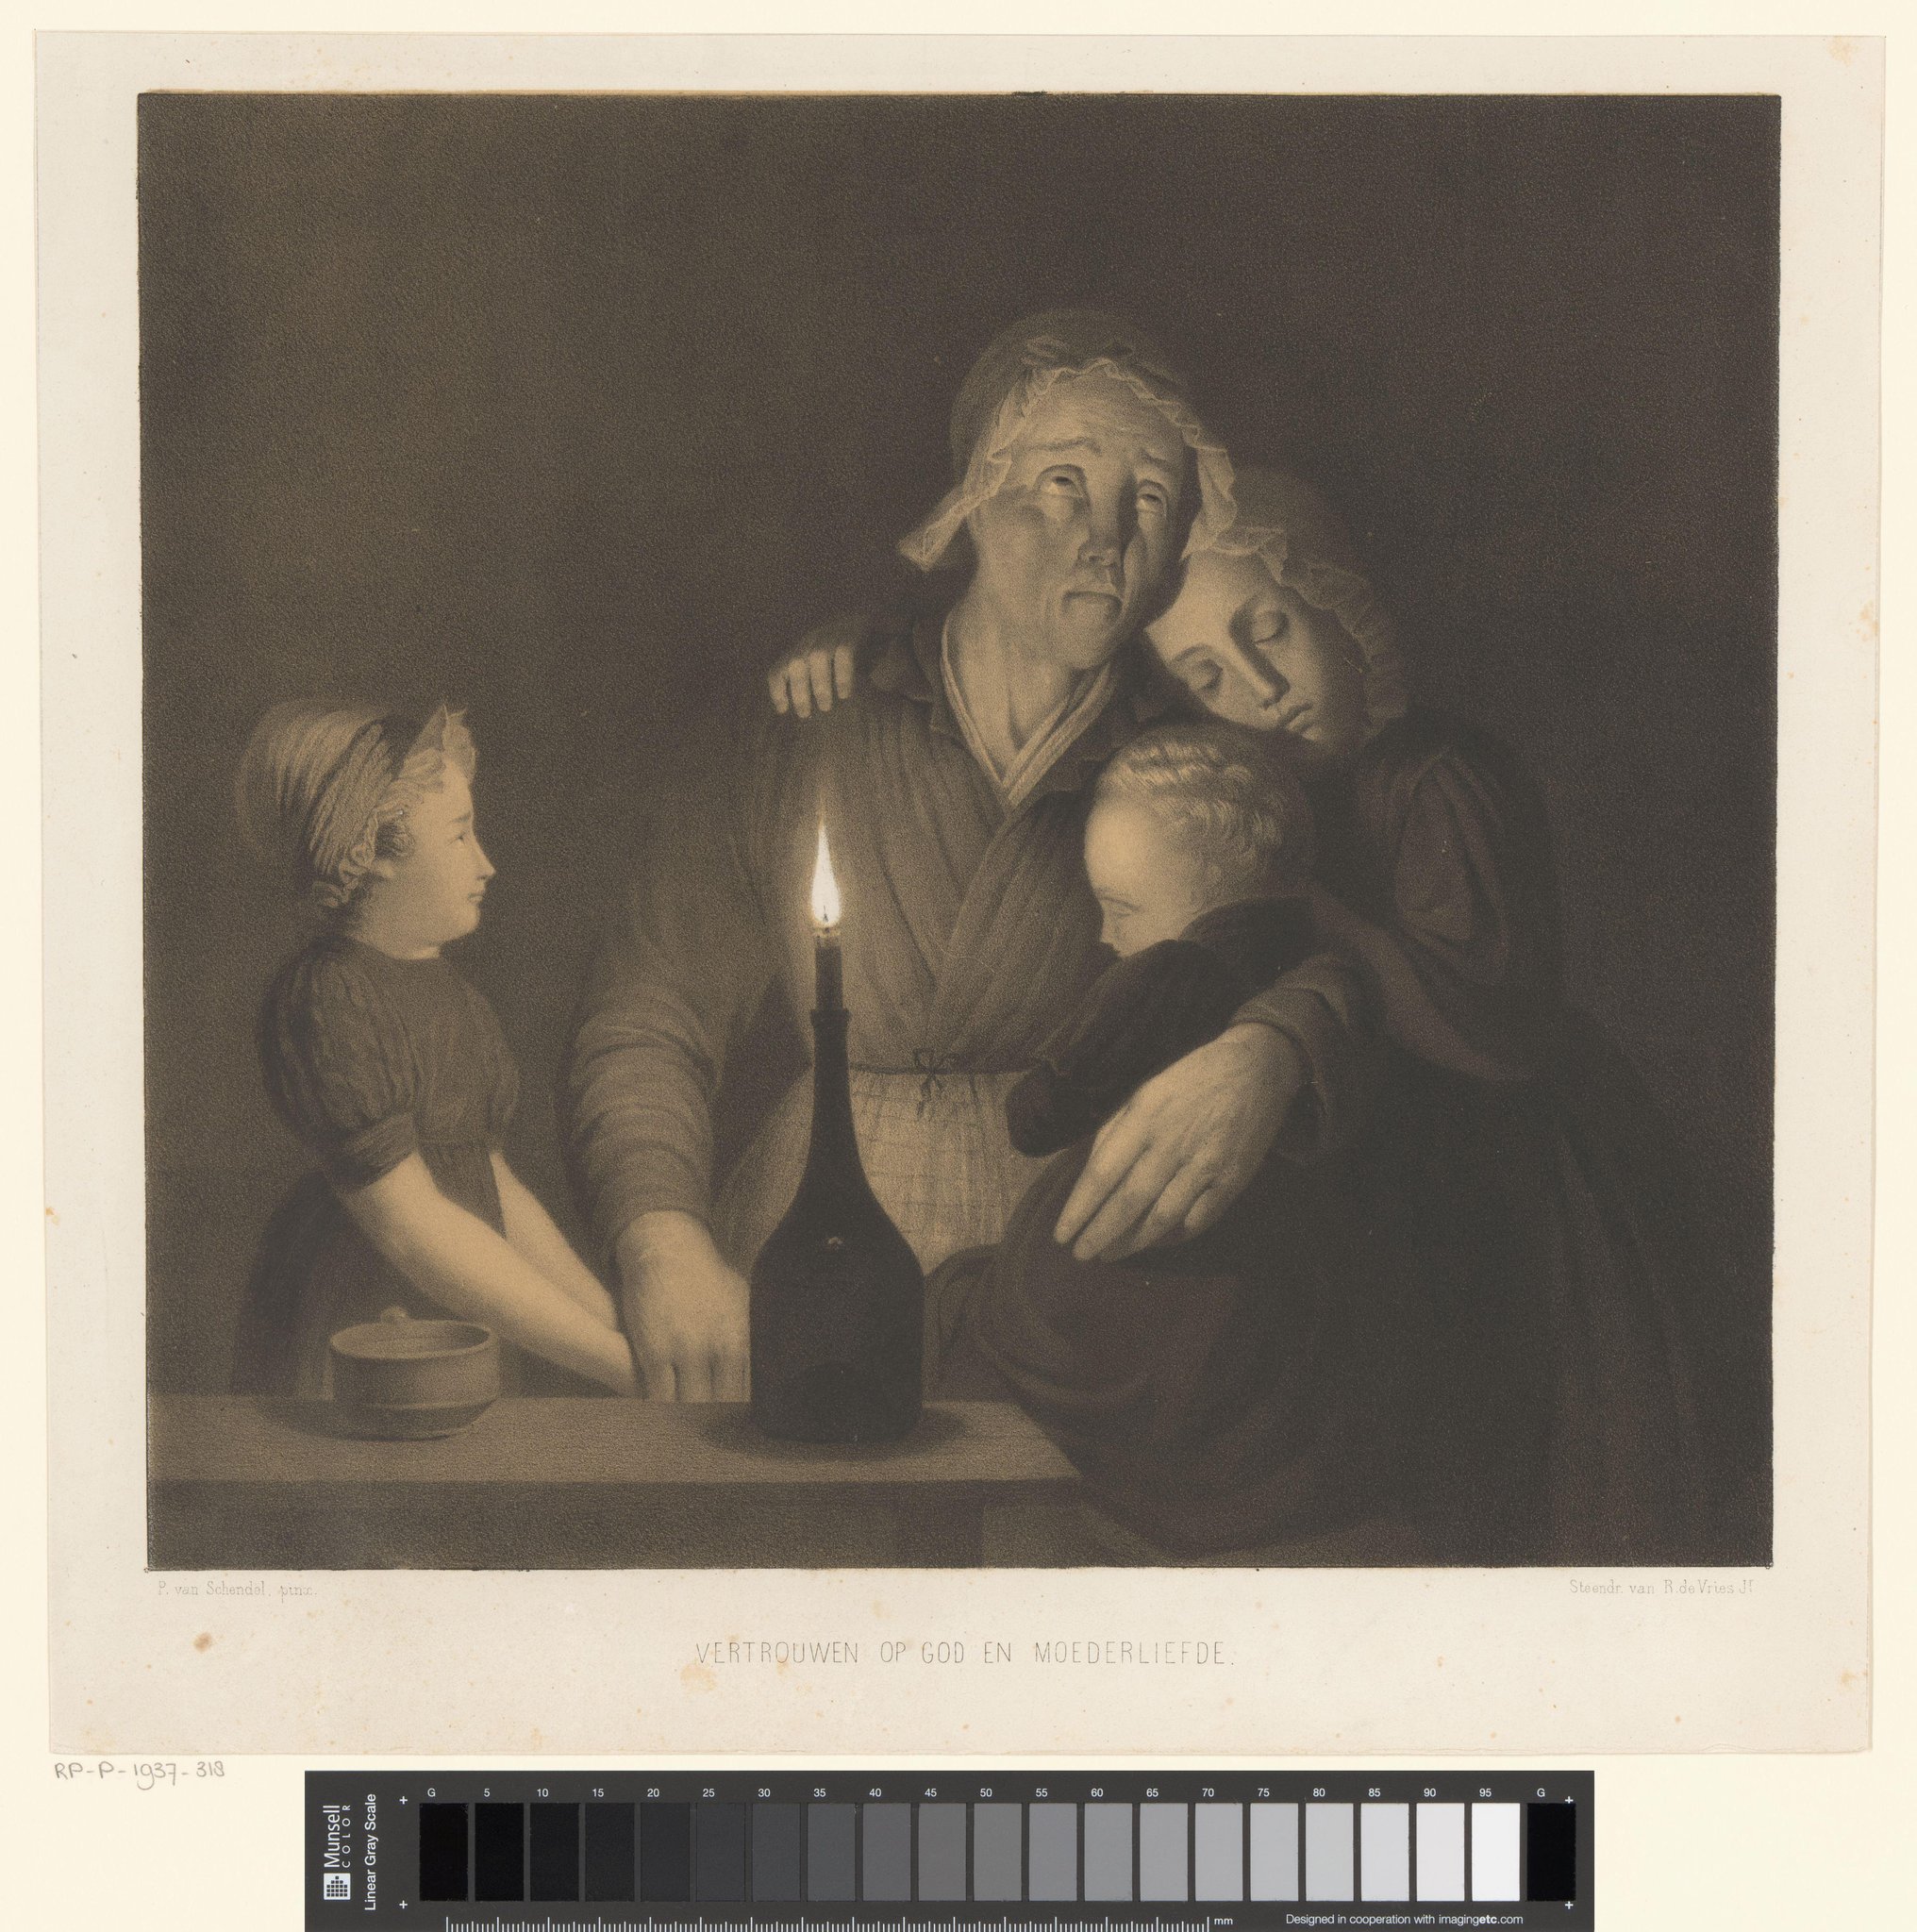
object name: print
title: Vertrouwen op God en moederliefde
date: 1823-1874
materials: paper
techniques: tone lithography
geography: netherlands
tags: mother-love, the worship of god, trust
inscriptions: collector's mark: Lugt 2760, collector's mark: Lugt 2228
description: Een moeder met haar drie kinderen staat bij een tafel waarop een brandende kaars staat.